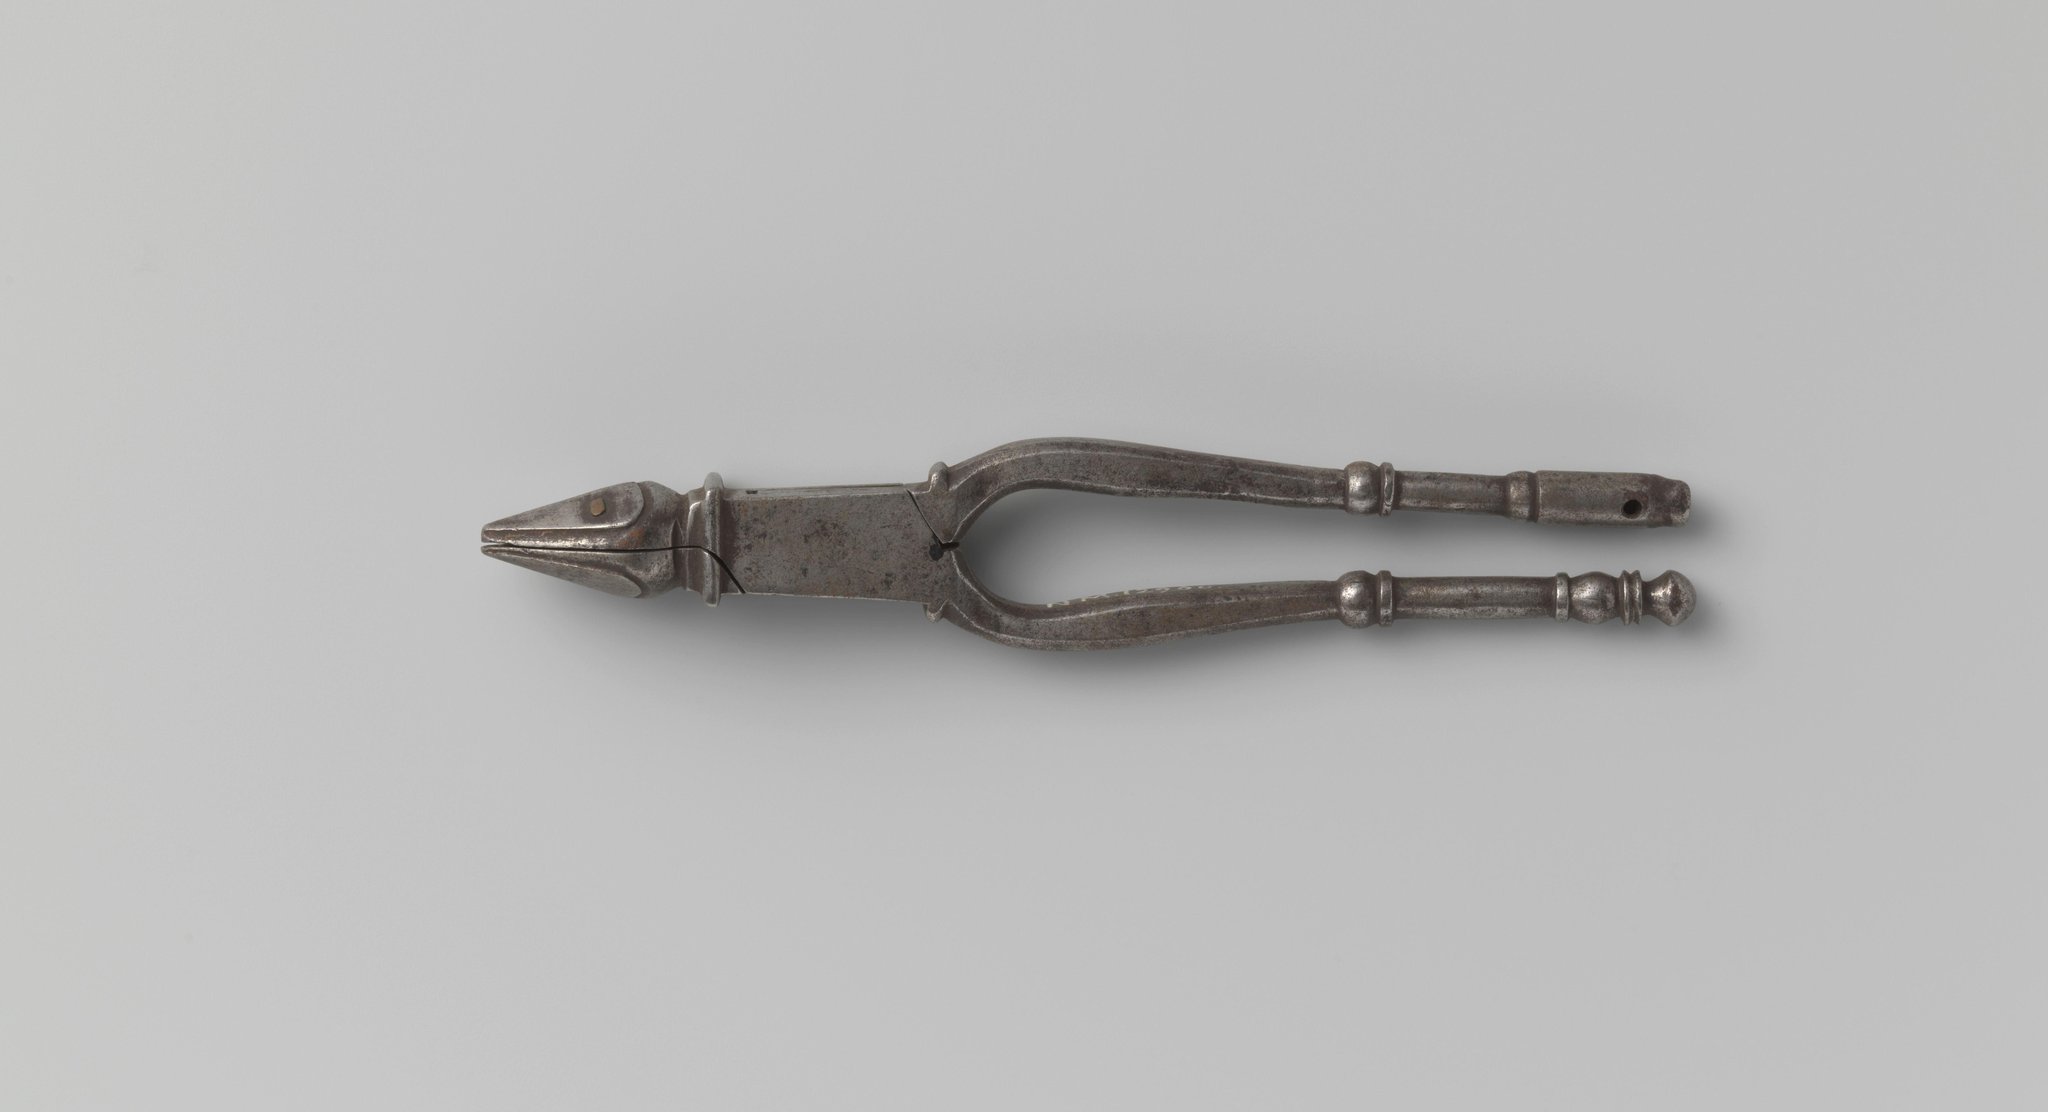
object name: nutcracker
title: Notenkraker in devorm van een spitse kop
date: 1700-1800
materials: iron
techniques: forging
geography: france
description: Een kleine gesmeed ijzeren tang, (noten- of amandelkraker). De bek in de vorm van een spitse kop met ingezette bronsen ogen; aan een der stangen een fluit.